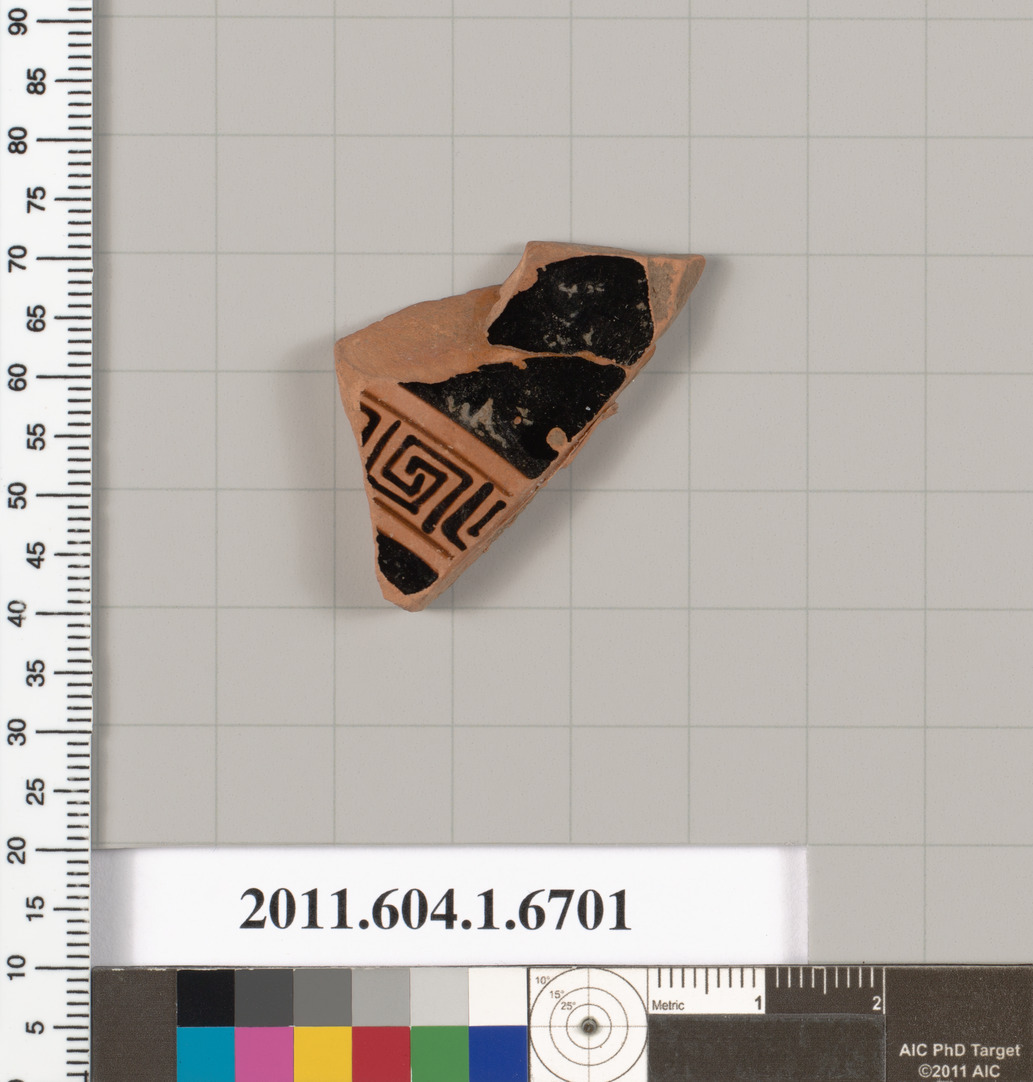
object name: kylix fragment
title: Terracotta fragment of a kylix (drinking cup)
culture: greek, attic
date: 490-470 BCE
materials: terracotta